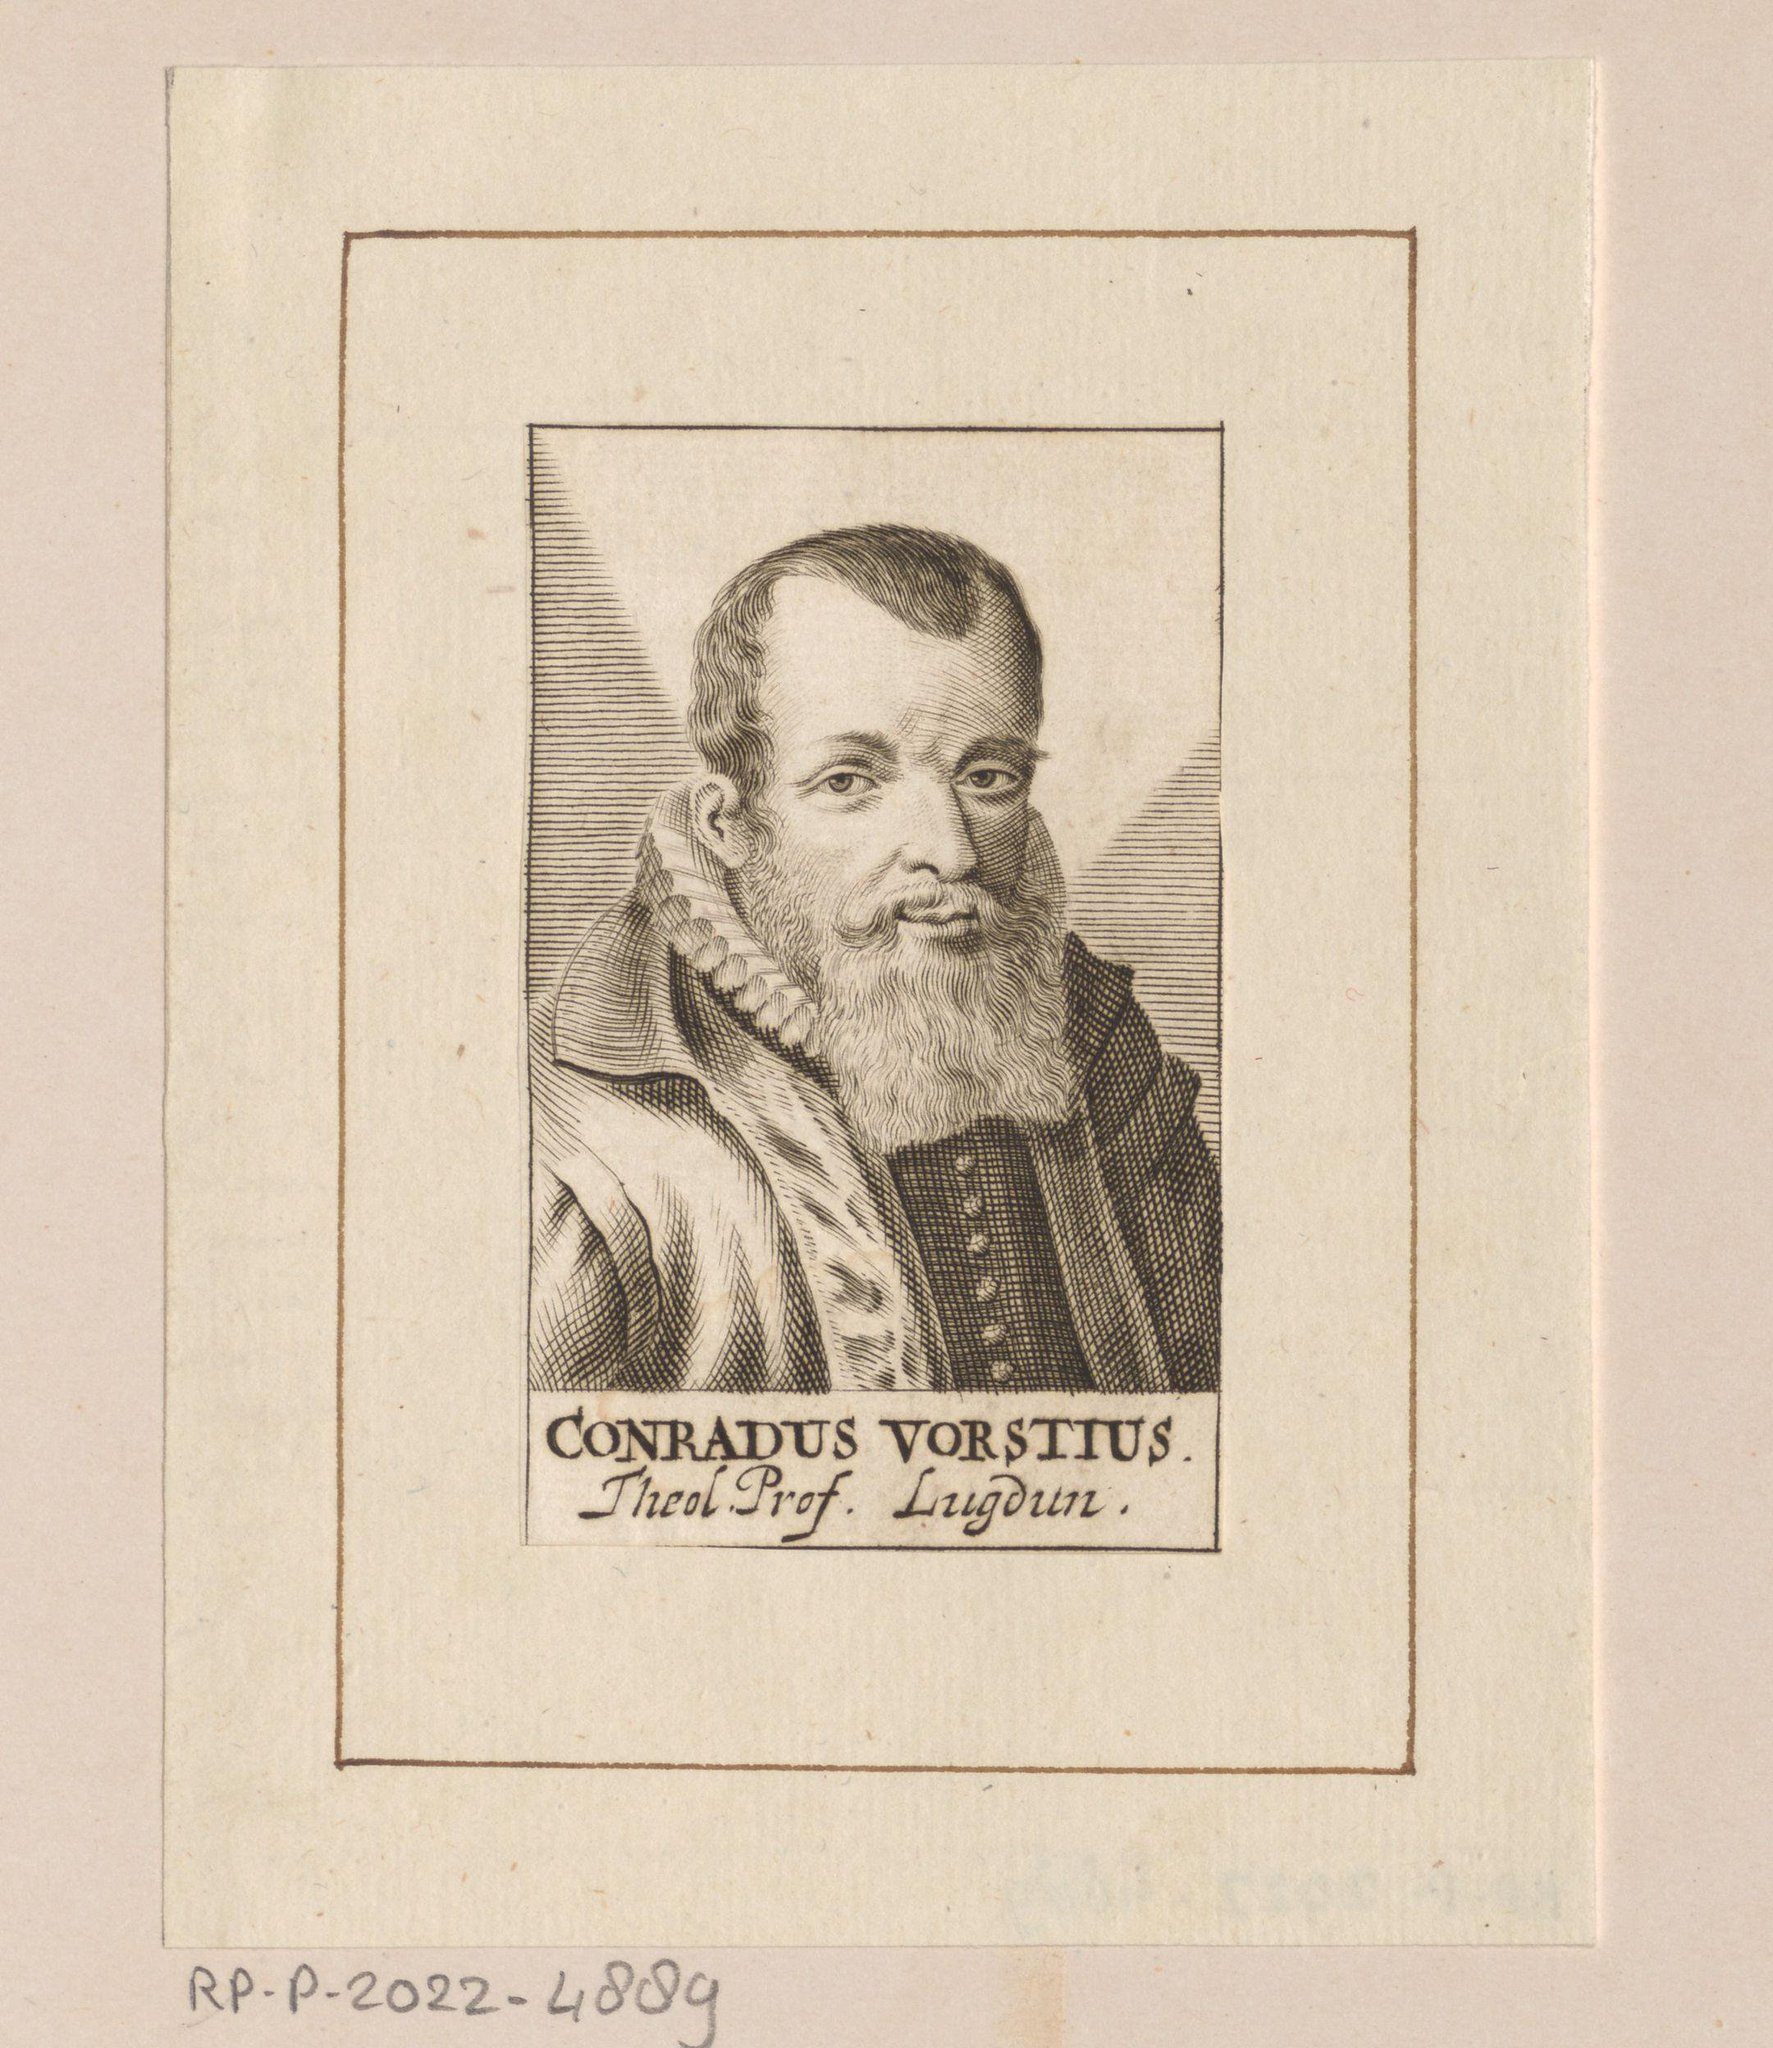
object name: print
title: Portret van Conradus Vorstius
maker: Anonymous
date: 1688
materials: paper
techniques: engraving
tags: theologian, historical persons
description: Prent waarschijnlijk uit: Freher, Paul. Theatrum Virorum Eruditione Clarorum Tomus Posterior. Neurenberg: Johann Hofmann, 1688.